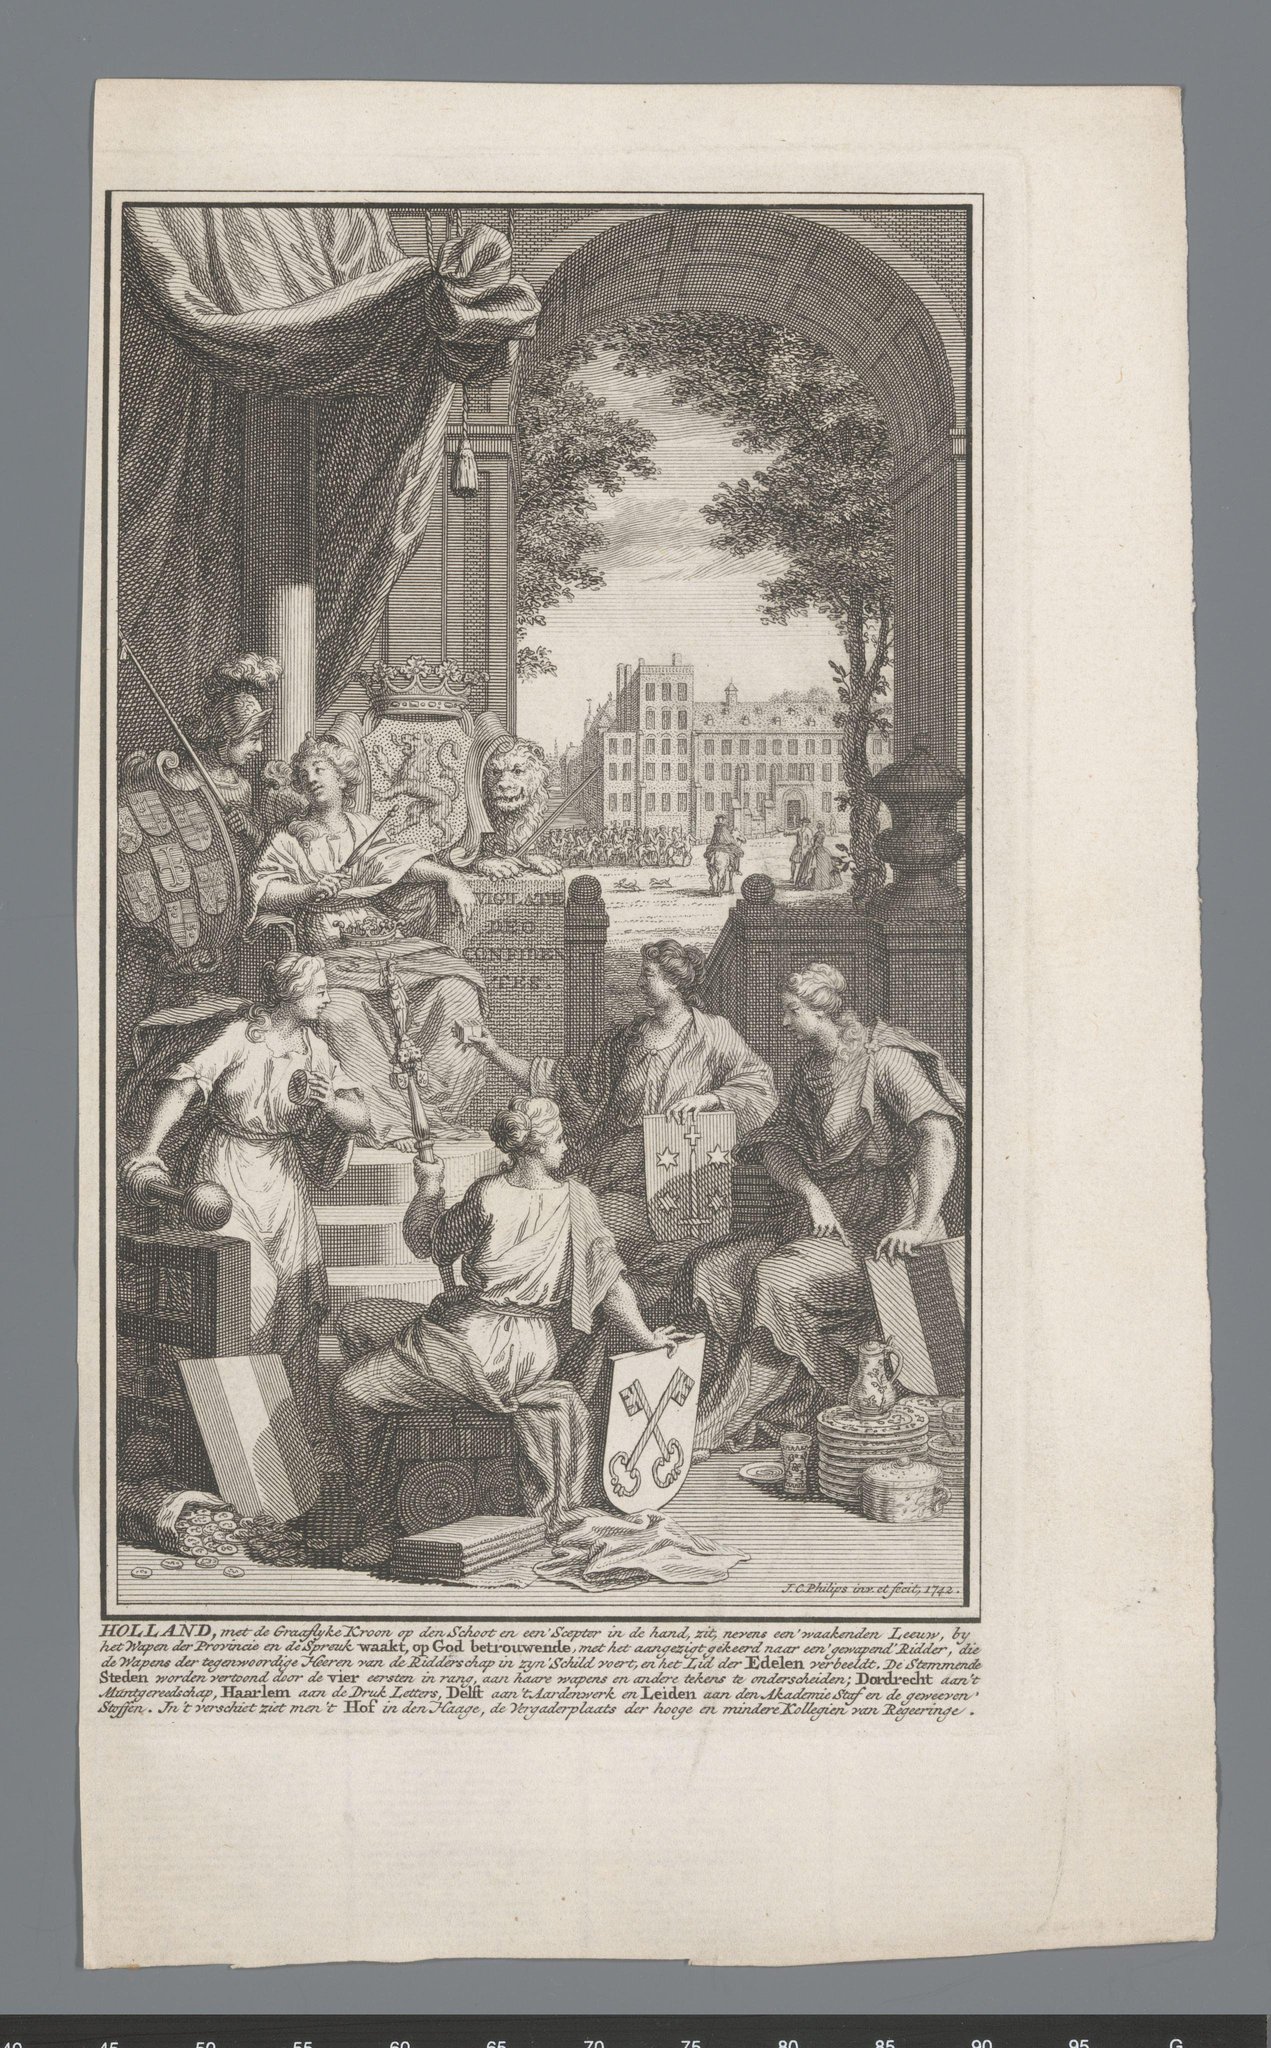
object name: print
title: Allegorie op Holland met het Hof in Den Haag op de achtergrond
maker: jan caspar philips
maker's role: draughtsman, print maker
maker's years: 1700-1775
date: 1742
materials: paper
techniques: engraving, etching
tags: personification of a city, town-patron(ess), the hague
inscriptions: date